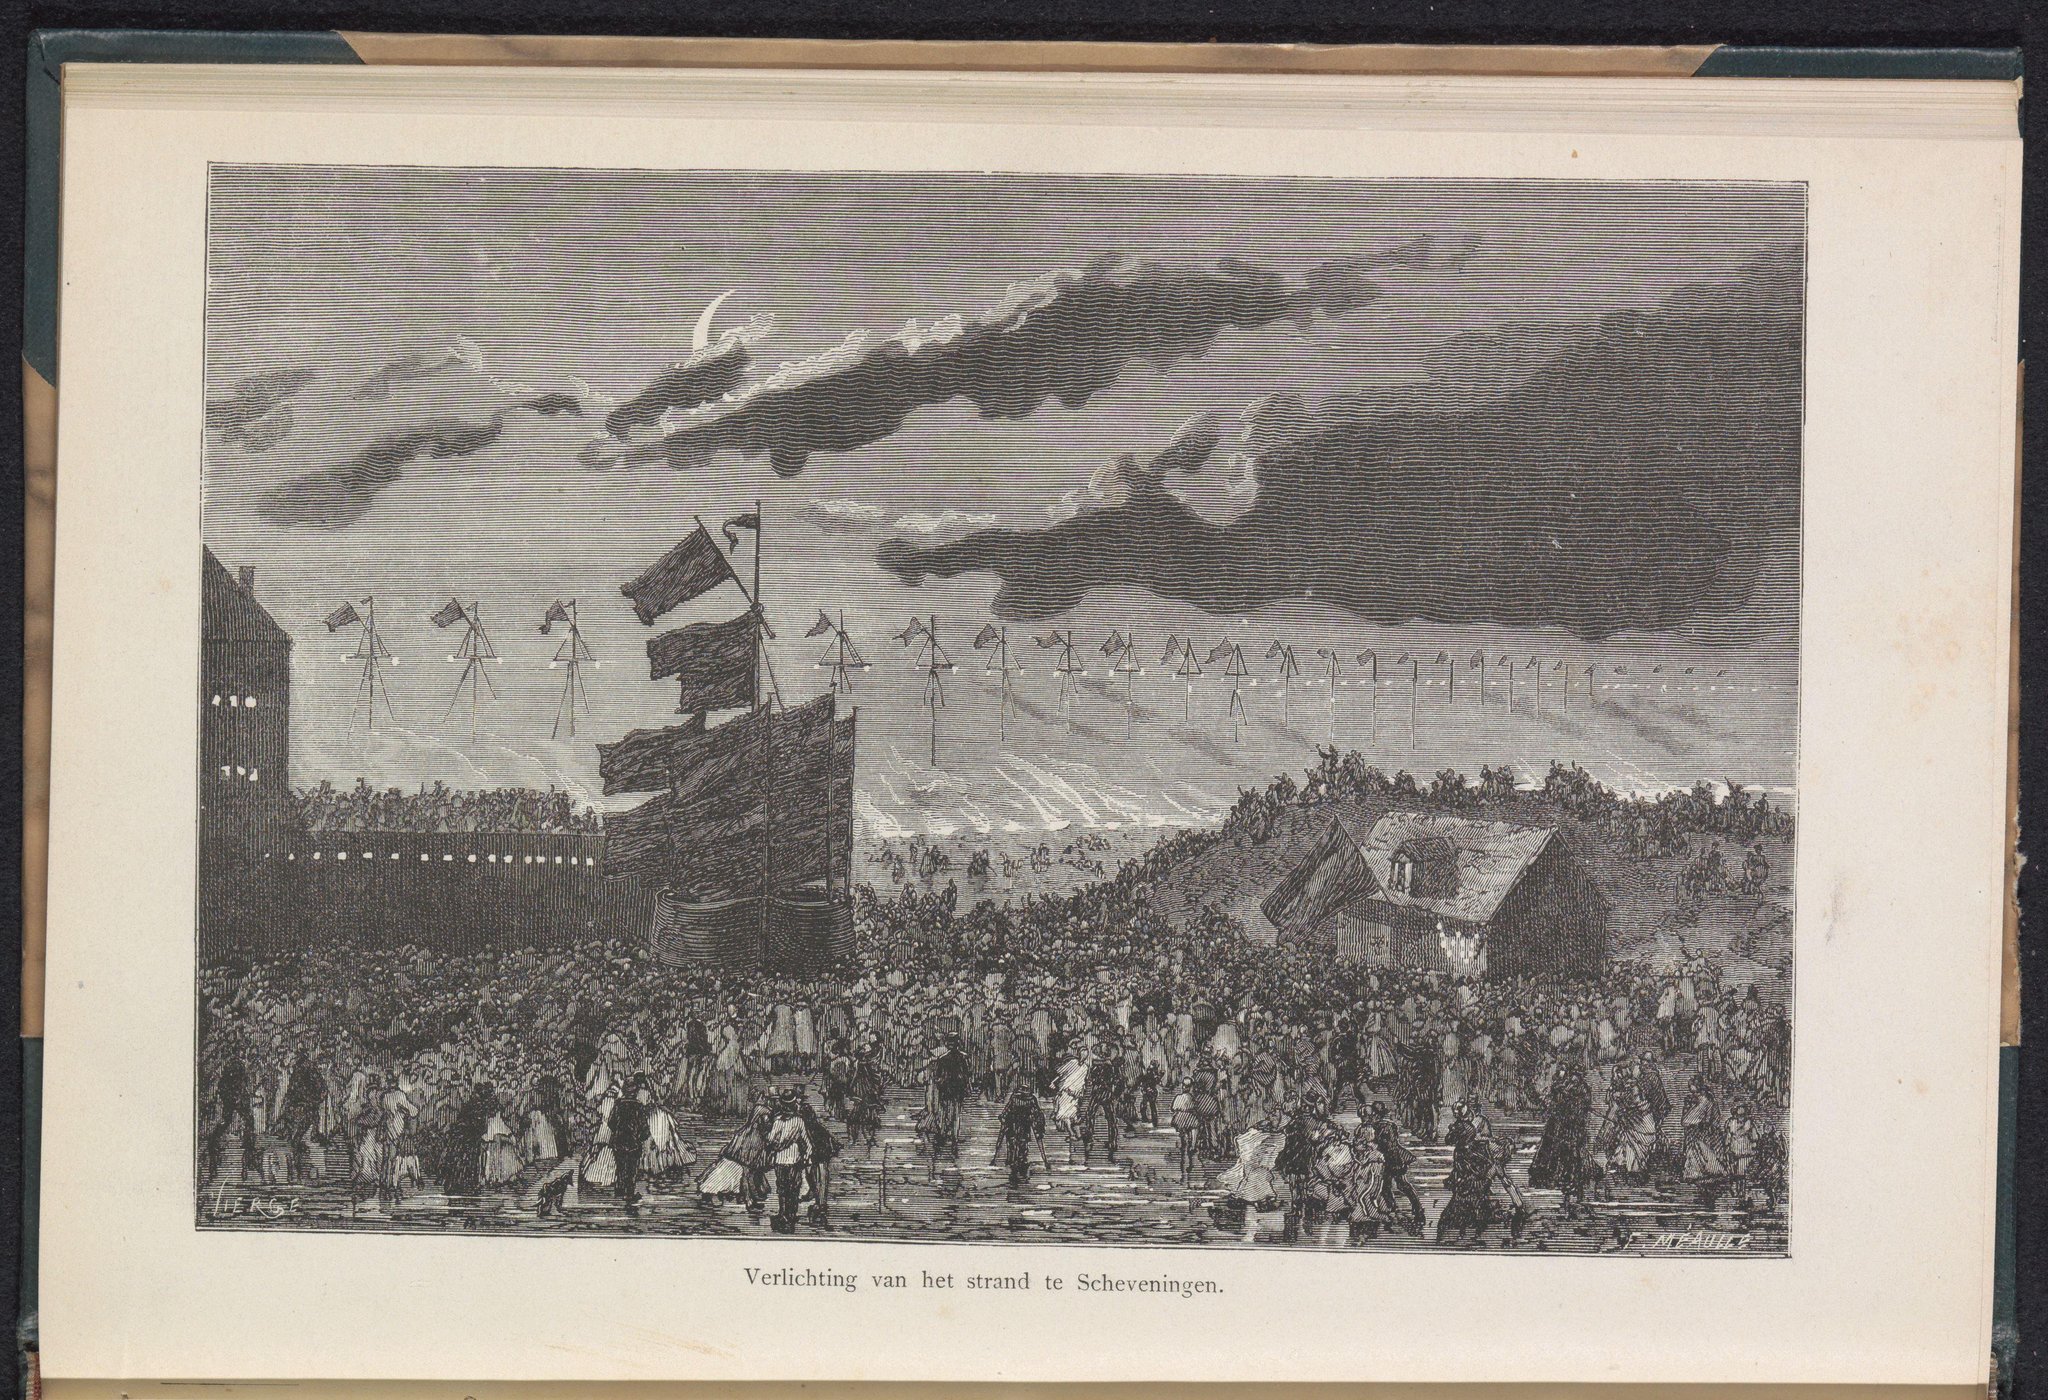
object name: book illustration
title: Illuminatie te Scheveningen, 1874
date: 1874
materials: paper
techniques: engraving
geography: arnhem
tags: brussels, willem iii (koning der nederlanden), public festivities at other royal events, not meant or mentioned above, public festivities at other royal events, not meant or mentioned above (+ illumination, fire-works ~ festive activities)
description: Illuminatie bij het strand van Scheveningen bij het bezoek van de koning, 19 mei 1874. Illustratie in een exemplaar van het gedenkboek van de feesten in mei 1874 ter gelegenheid van het 25-jarige regeringsjubileum van koning Willem III.